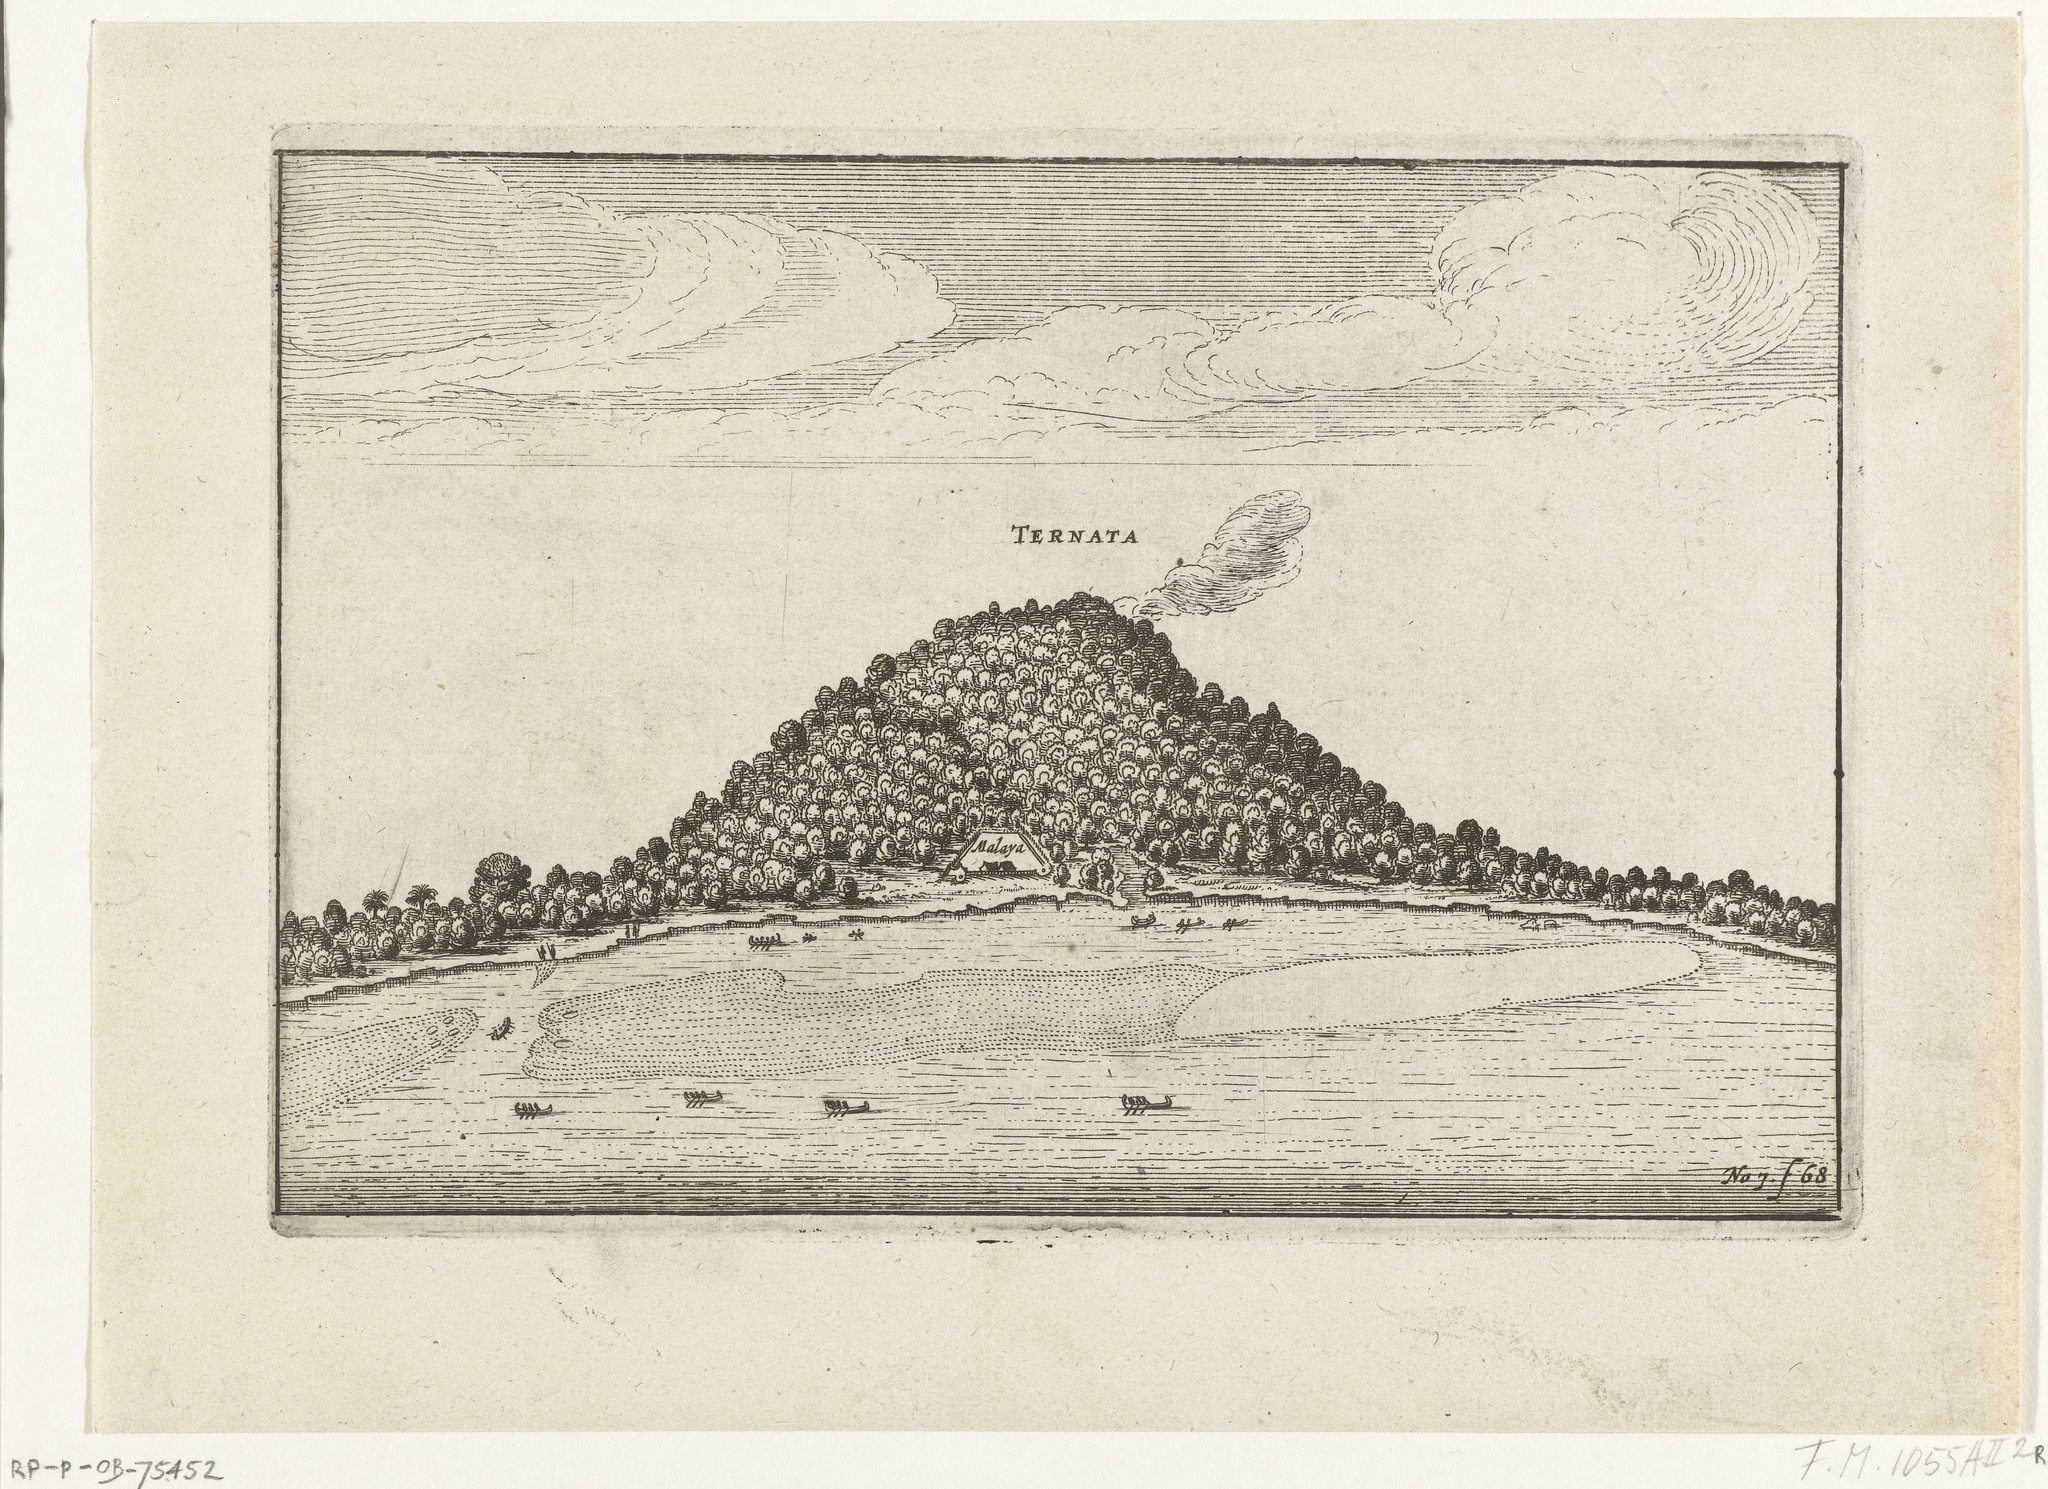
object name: print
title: Ternata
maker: Anonymous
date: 1644-1646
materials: paper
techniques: etching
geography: northern netherlands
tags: mayor, landscapes in tropical and sub-tropical regions, exploration, expedition, voyage of discovery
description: Gebruikt als illustratie: Historisch Verhael Vande treffelijcke Reyse, gedaen naer de Oost-Indien ende China, met elf Schepen. Door den Manhaften Admirael Cornelis Matelief de Jonge. Inden Jaren 1605. 1606. 1607. ende 1608. Deze tekst opgenomen in : I. Commelin, Begin ende voortgangh, van de Vereenighde Nederlantsche Geoctroyeerde Oost-Indische Compagnie, J. Janssonius, Amsterdam 1646. Genummerd: No. 7.